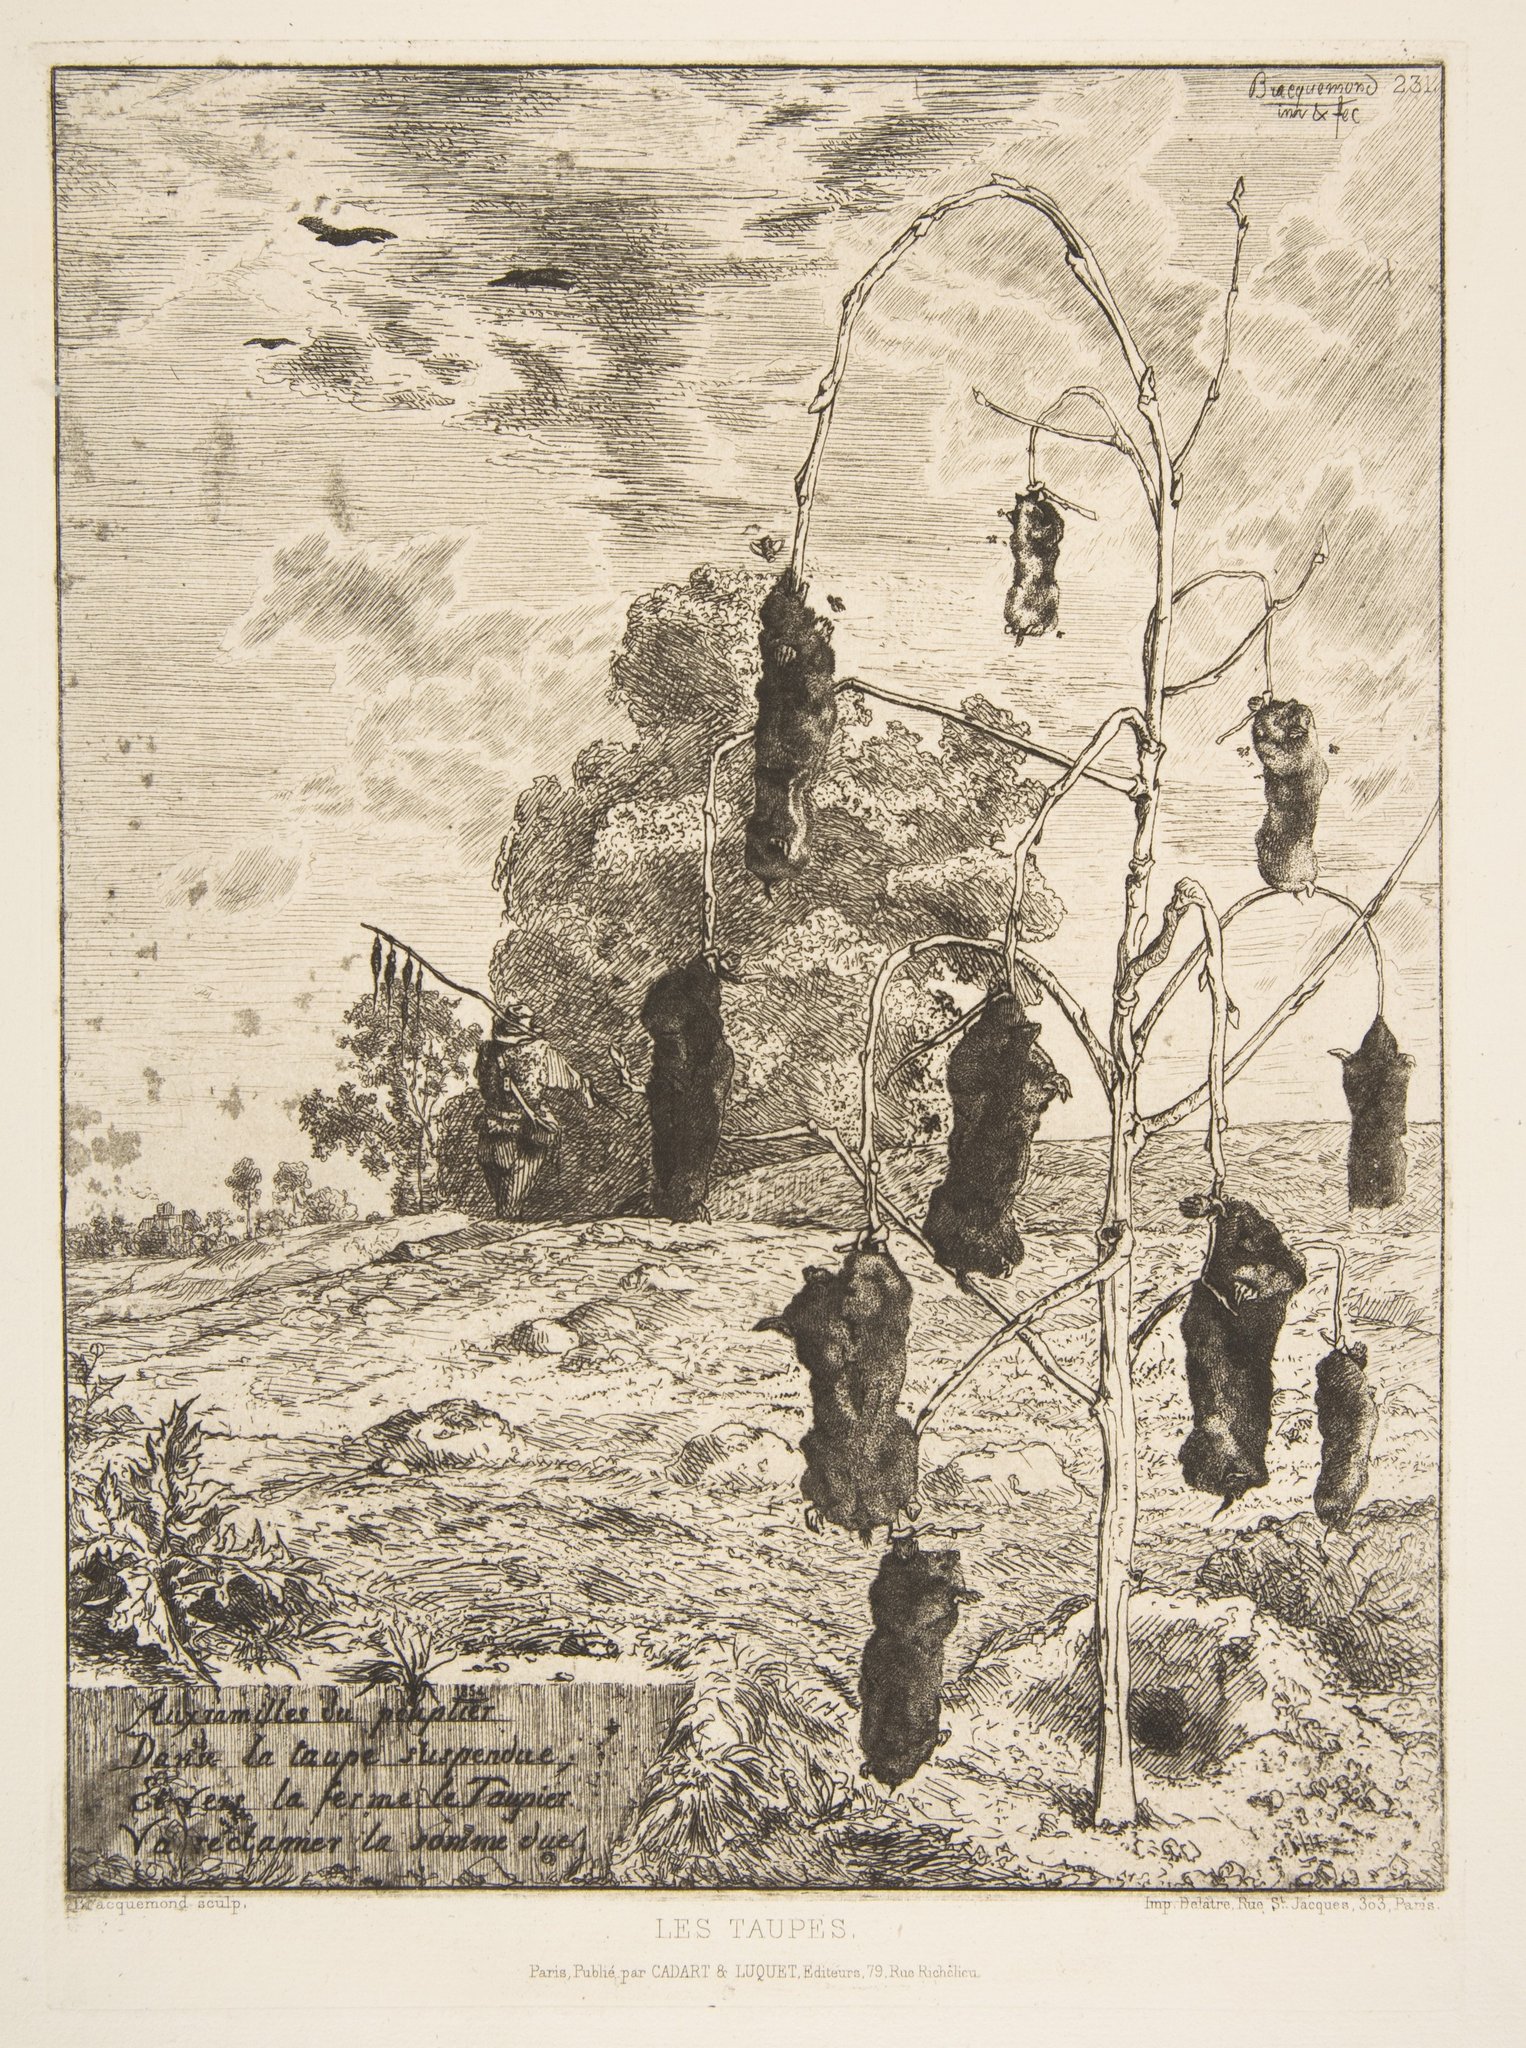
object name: print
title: Les Taupes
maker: félix bracquemond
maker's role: artist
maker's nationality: french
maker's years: 1833-1914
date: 1854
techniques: etching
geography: france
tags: animals,trees